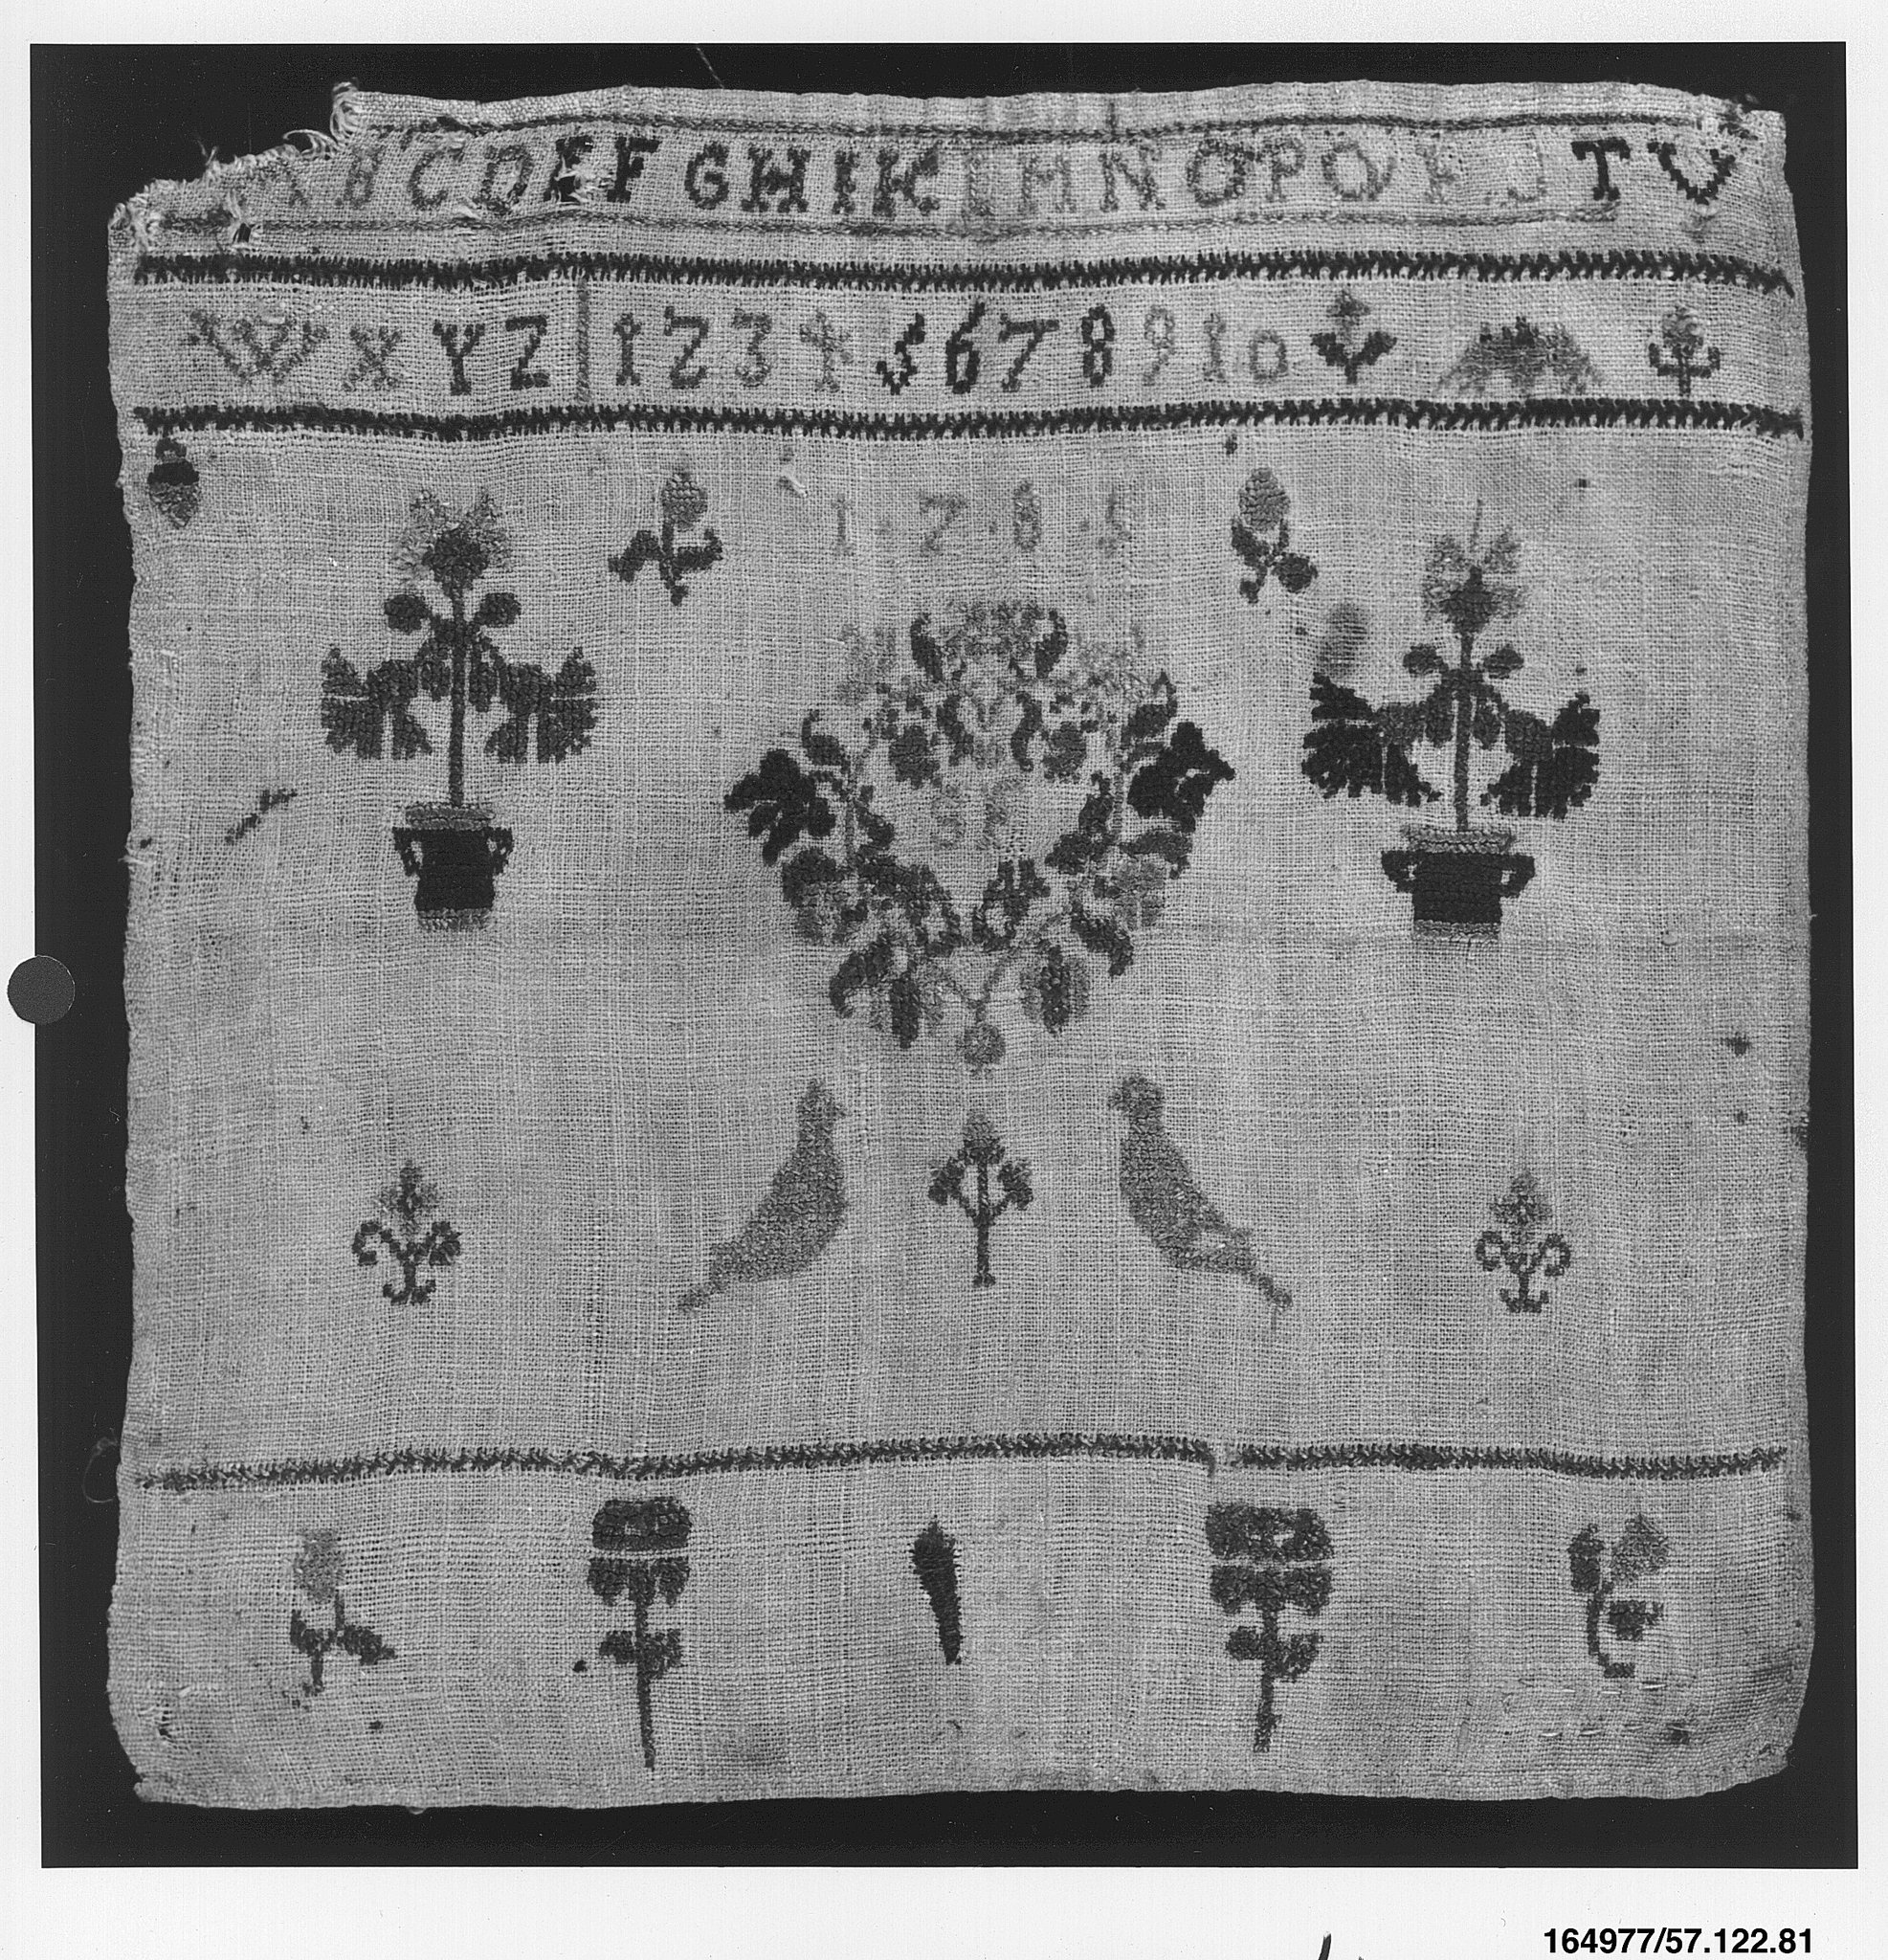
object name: sampler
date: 1785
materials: linen, silk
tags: birds,flowers,insignia